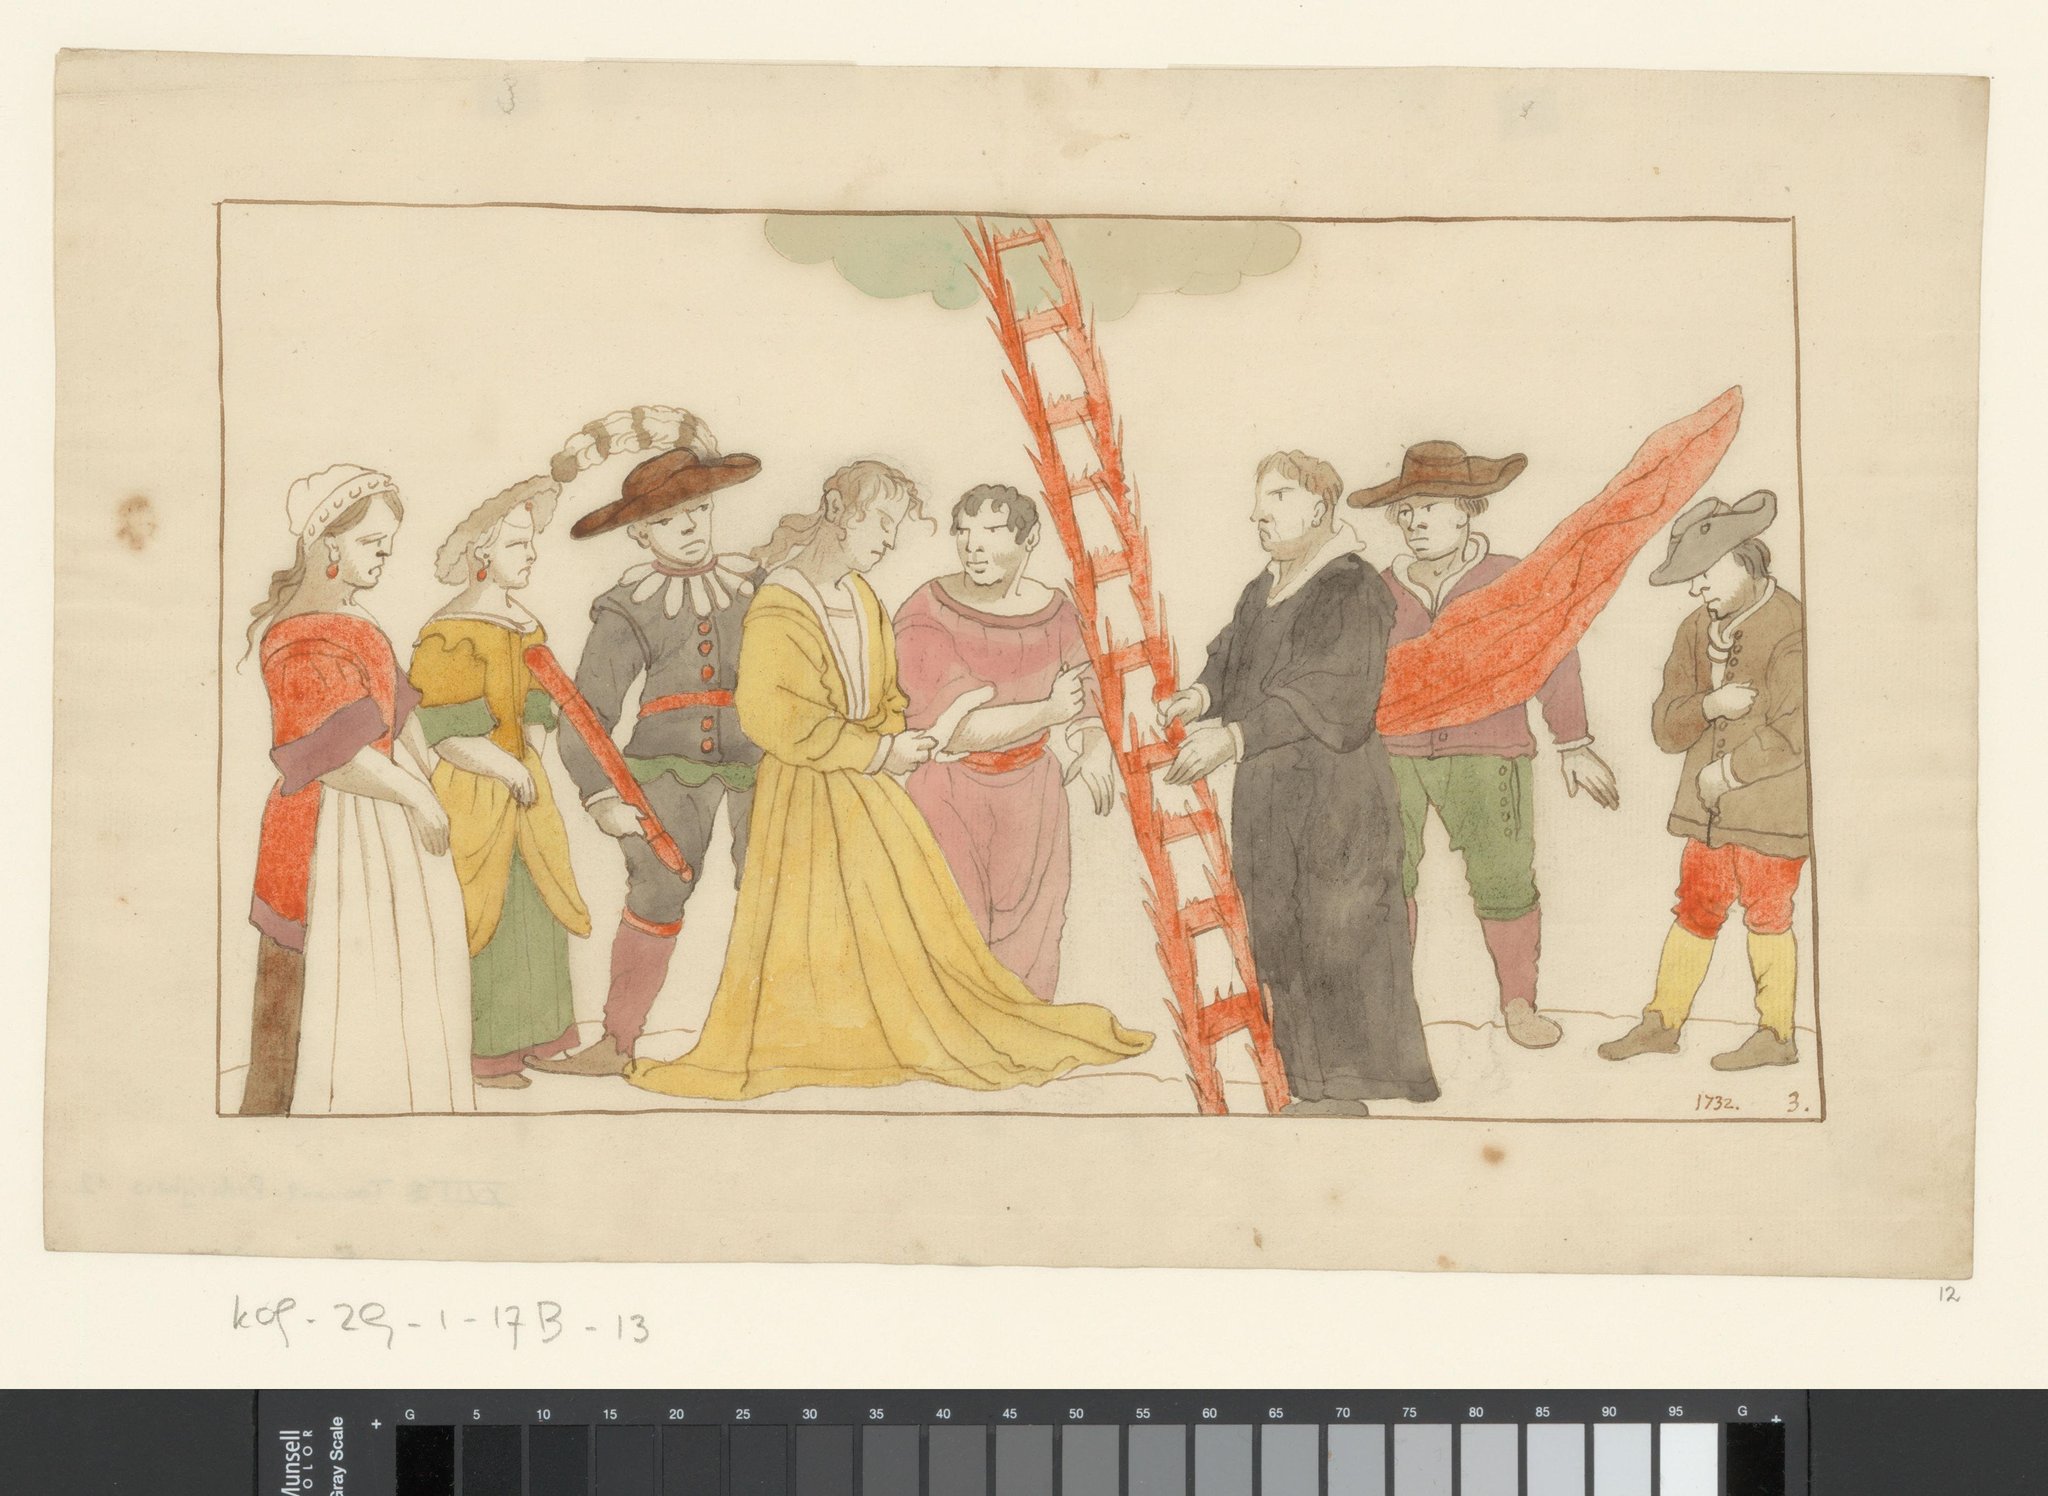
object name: drawing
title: Martin Luther biedt een vrouw een stekelige ladder naar de hemel aan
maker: Anonymous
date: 1800-1847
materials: ink, paper, watercolor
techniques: brush, pen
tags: priest, martin luther, female angels, theatre, theatrical performance, chamber of rhetoric (dutch: 'rederijkerskamer'), ladder, ladder, stairway to heaven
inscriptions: stamp, collector's mark: Lugt 1641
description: Tekeningen beschreven in: Leer-comoedie in Brabant, Eene irenische proeve uit vroegeren tijd. Uit: Archief voor kerkelijke geschiedenis, inzonderheid van Nederland (...). Leiden: S. en J. Luchtmans, 1847, dl. 8.